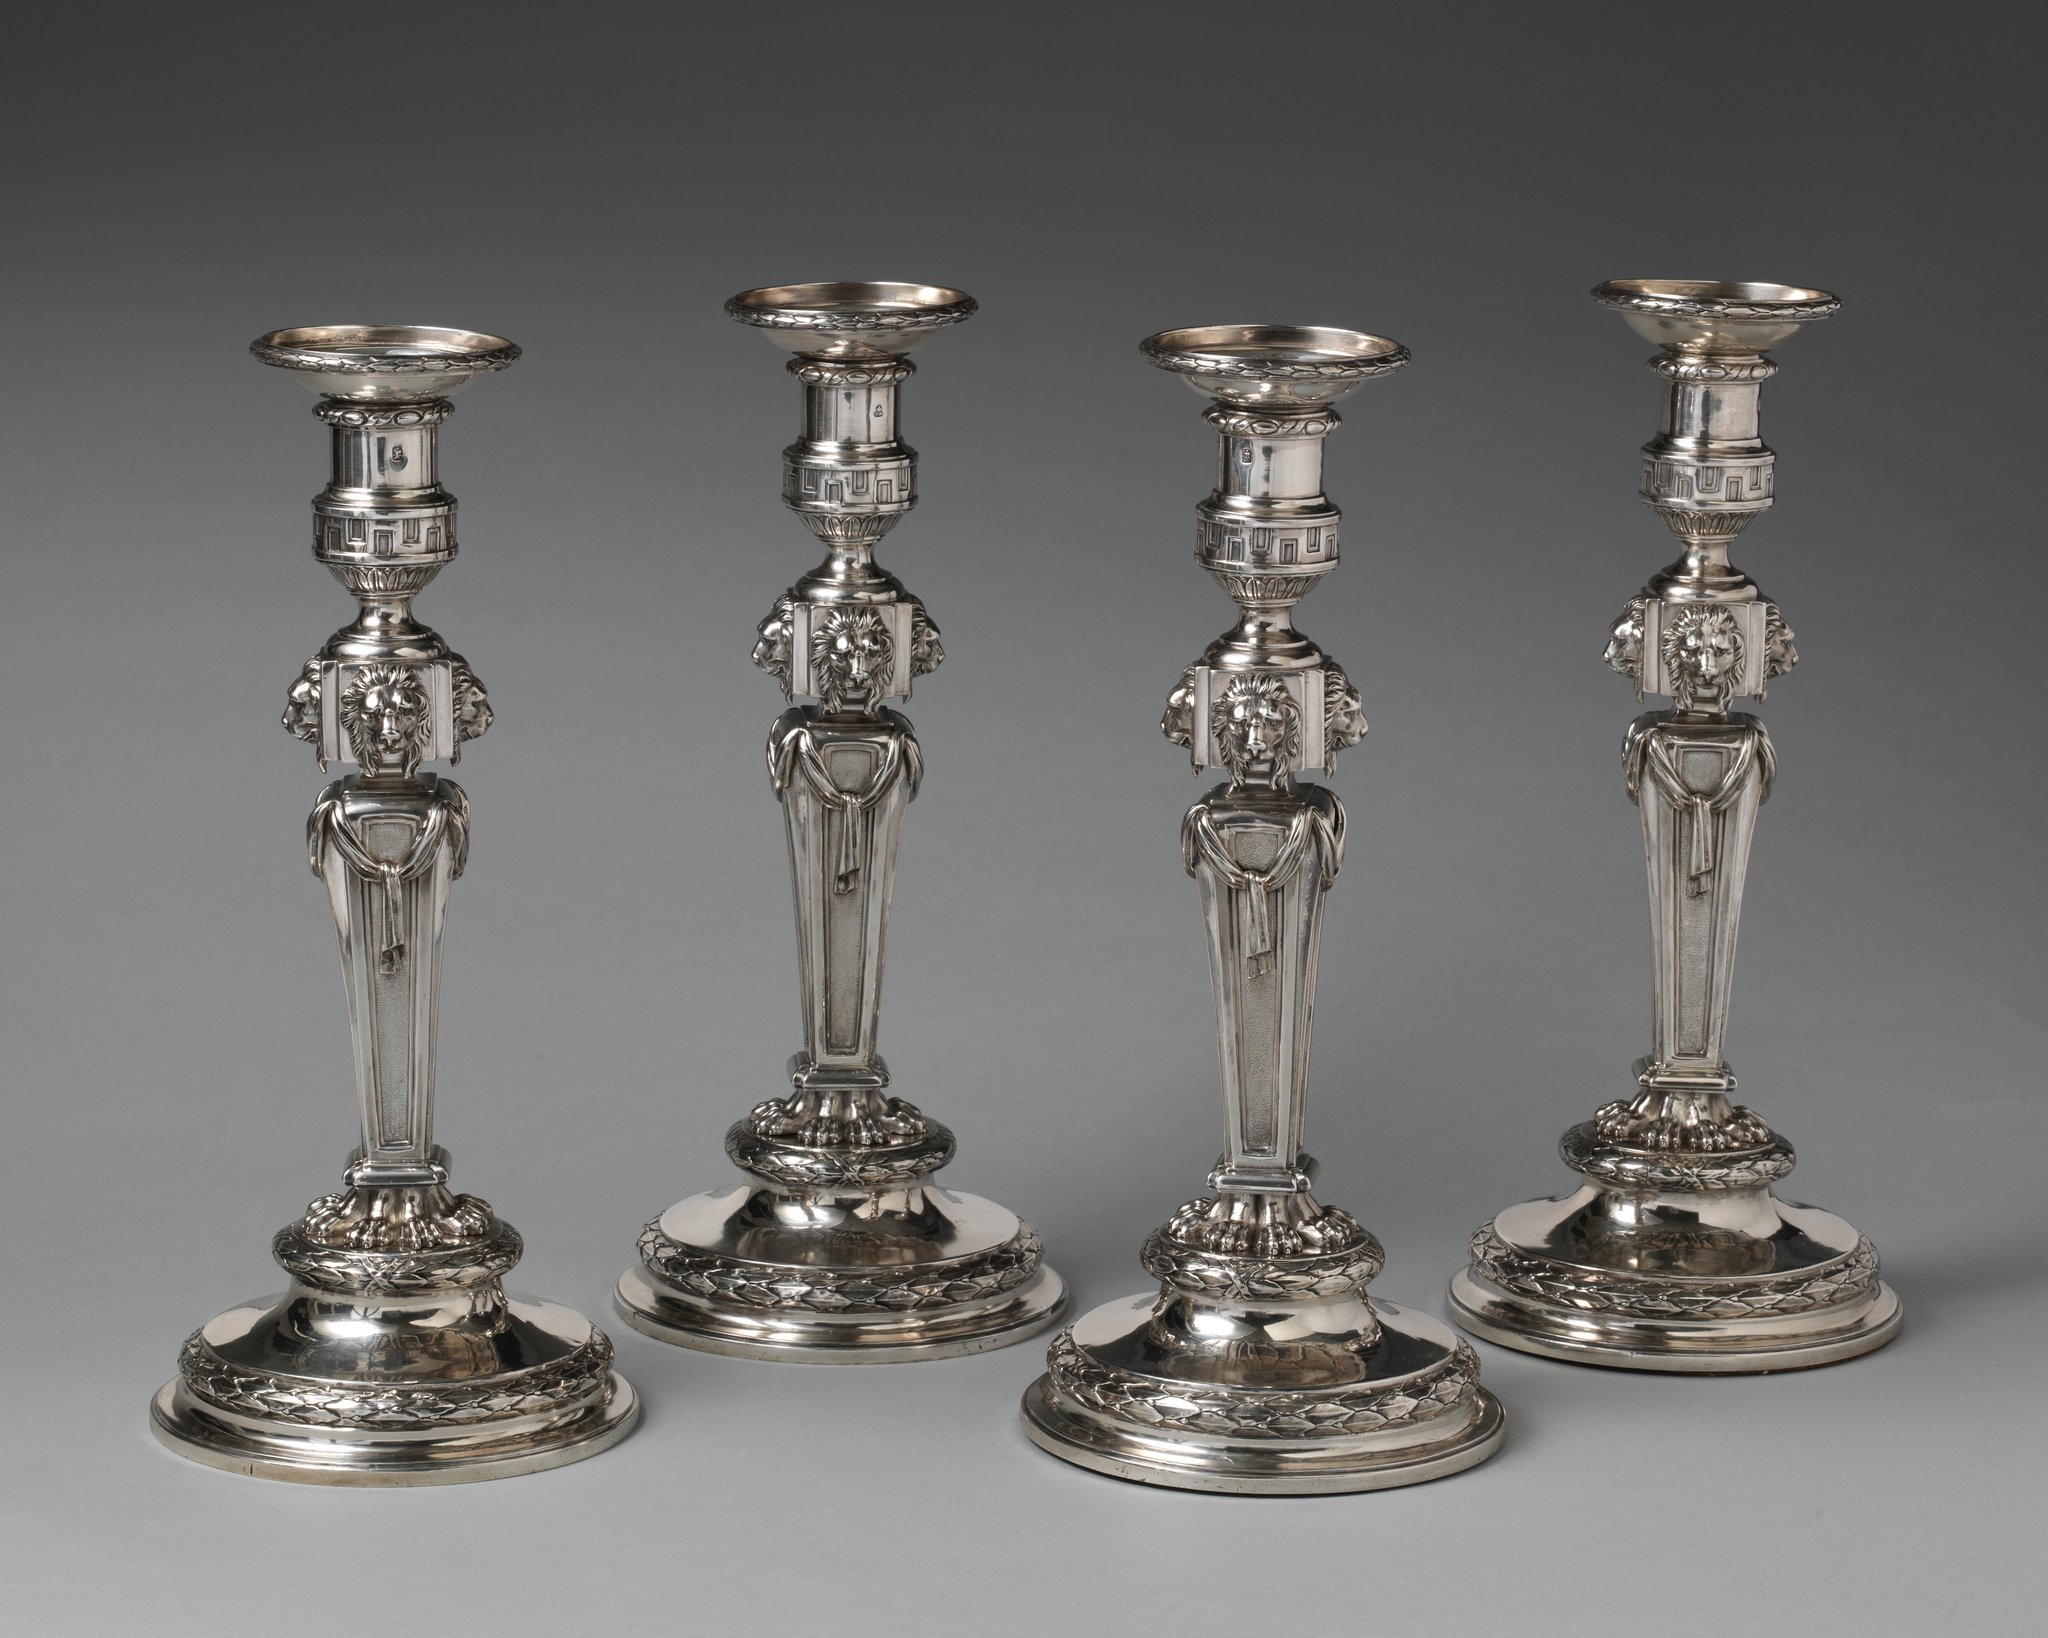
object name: candlestick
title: Set of four candlesticks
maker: thomas heming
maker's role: maker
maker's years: 1745-1773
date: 1771-1773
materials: silver